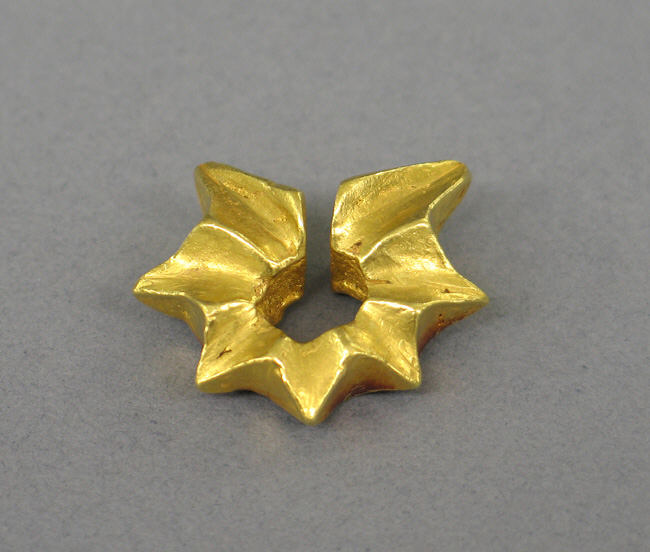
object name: ear clip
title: Ear Clip in the Shape of a Starfruit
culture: indonesian, javanese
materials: gold